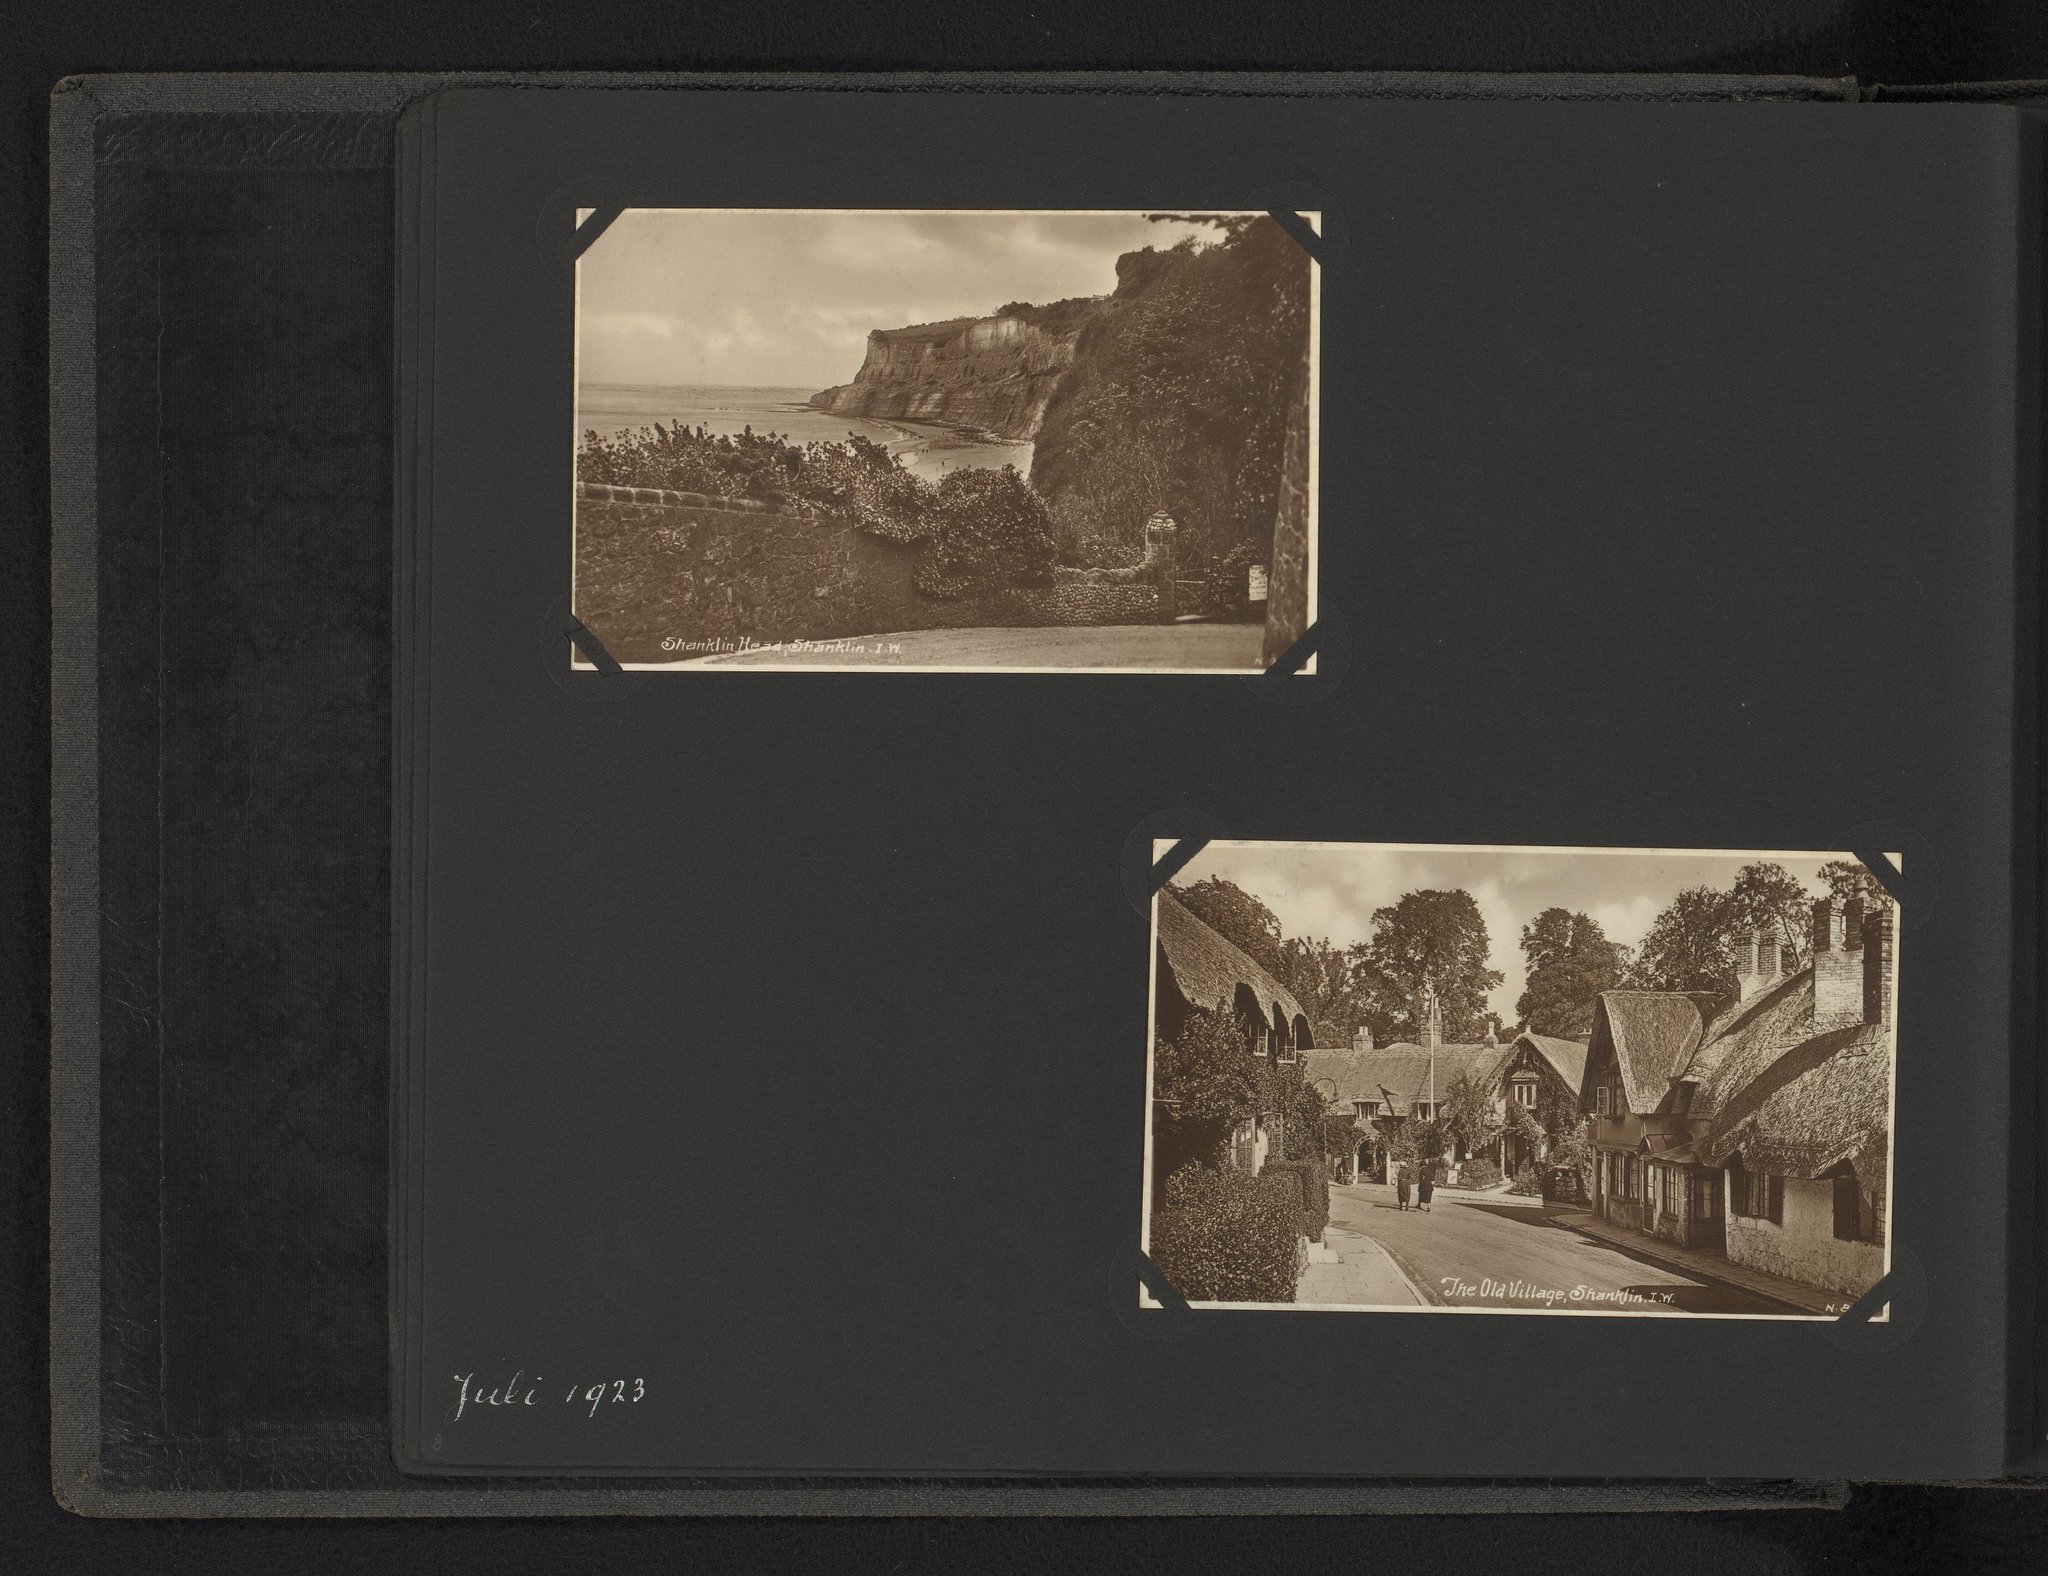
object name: ansichtkaart, prentbriefkaart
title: Twee fotografische prentbriefkaarten van Shanklin op de Isle of Wight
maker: Anonymous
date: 1907-1923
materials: paper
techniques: gelatin silver print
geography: isle of wight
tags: village, coastal cliff or crag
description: Deze foto's maken deel uit van een album.